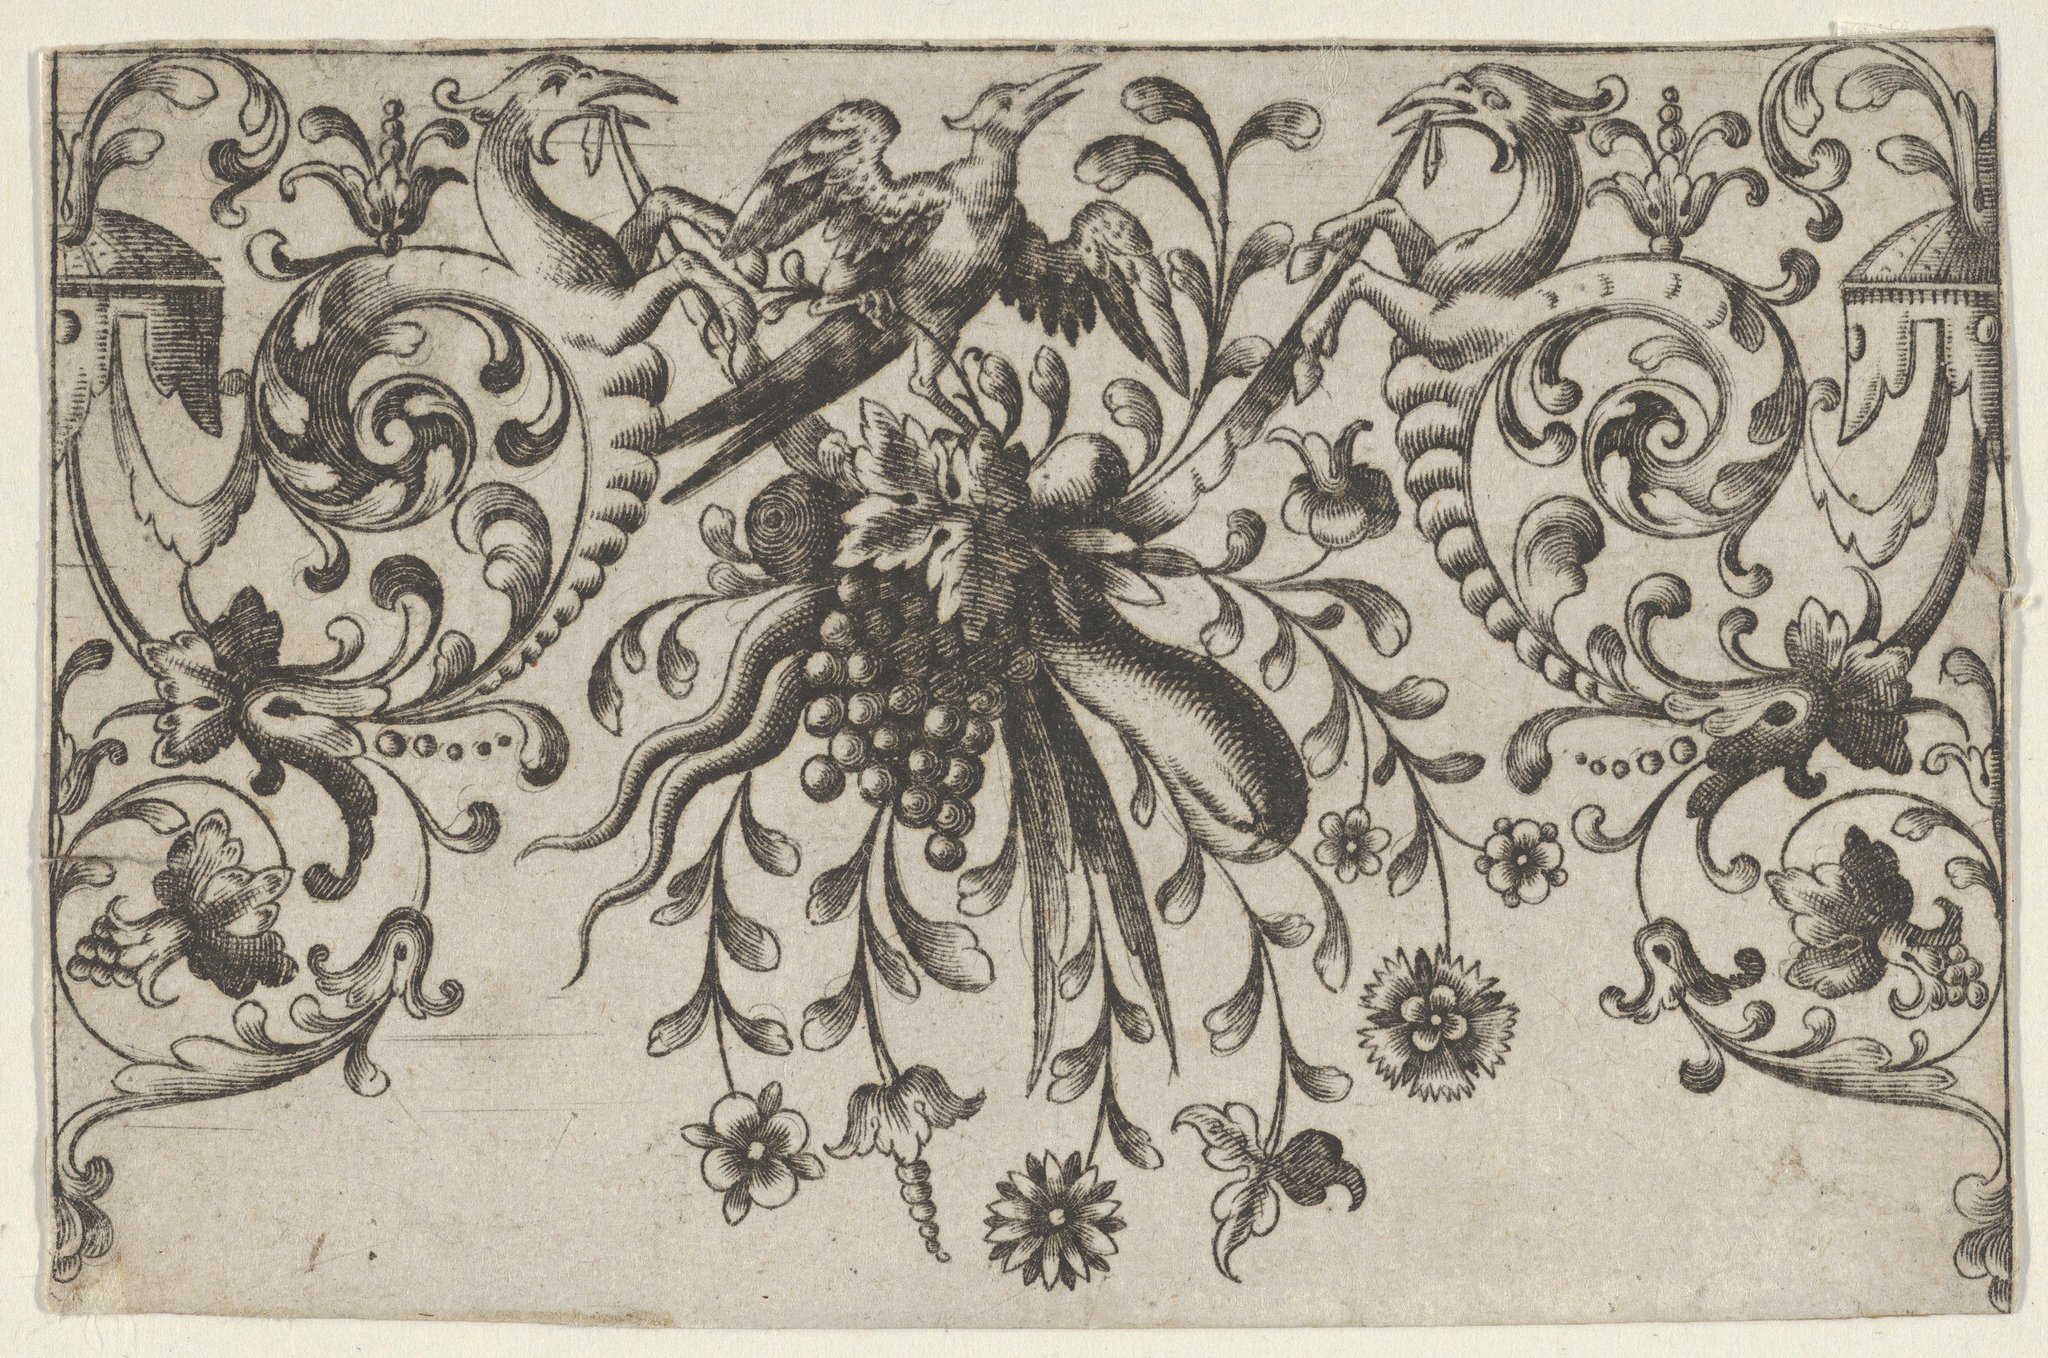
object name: print ornament architecture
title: Design for Silverwork with Garlands, Birds, and Grotesque Motifs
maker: hieronymus bang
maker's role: artist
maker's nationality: german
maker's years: 1553-1630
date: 1568-1633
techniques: engraving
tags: birds,garlands,grotesques,ornament